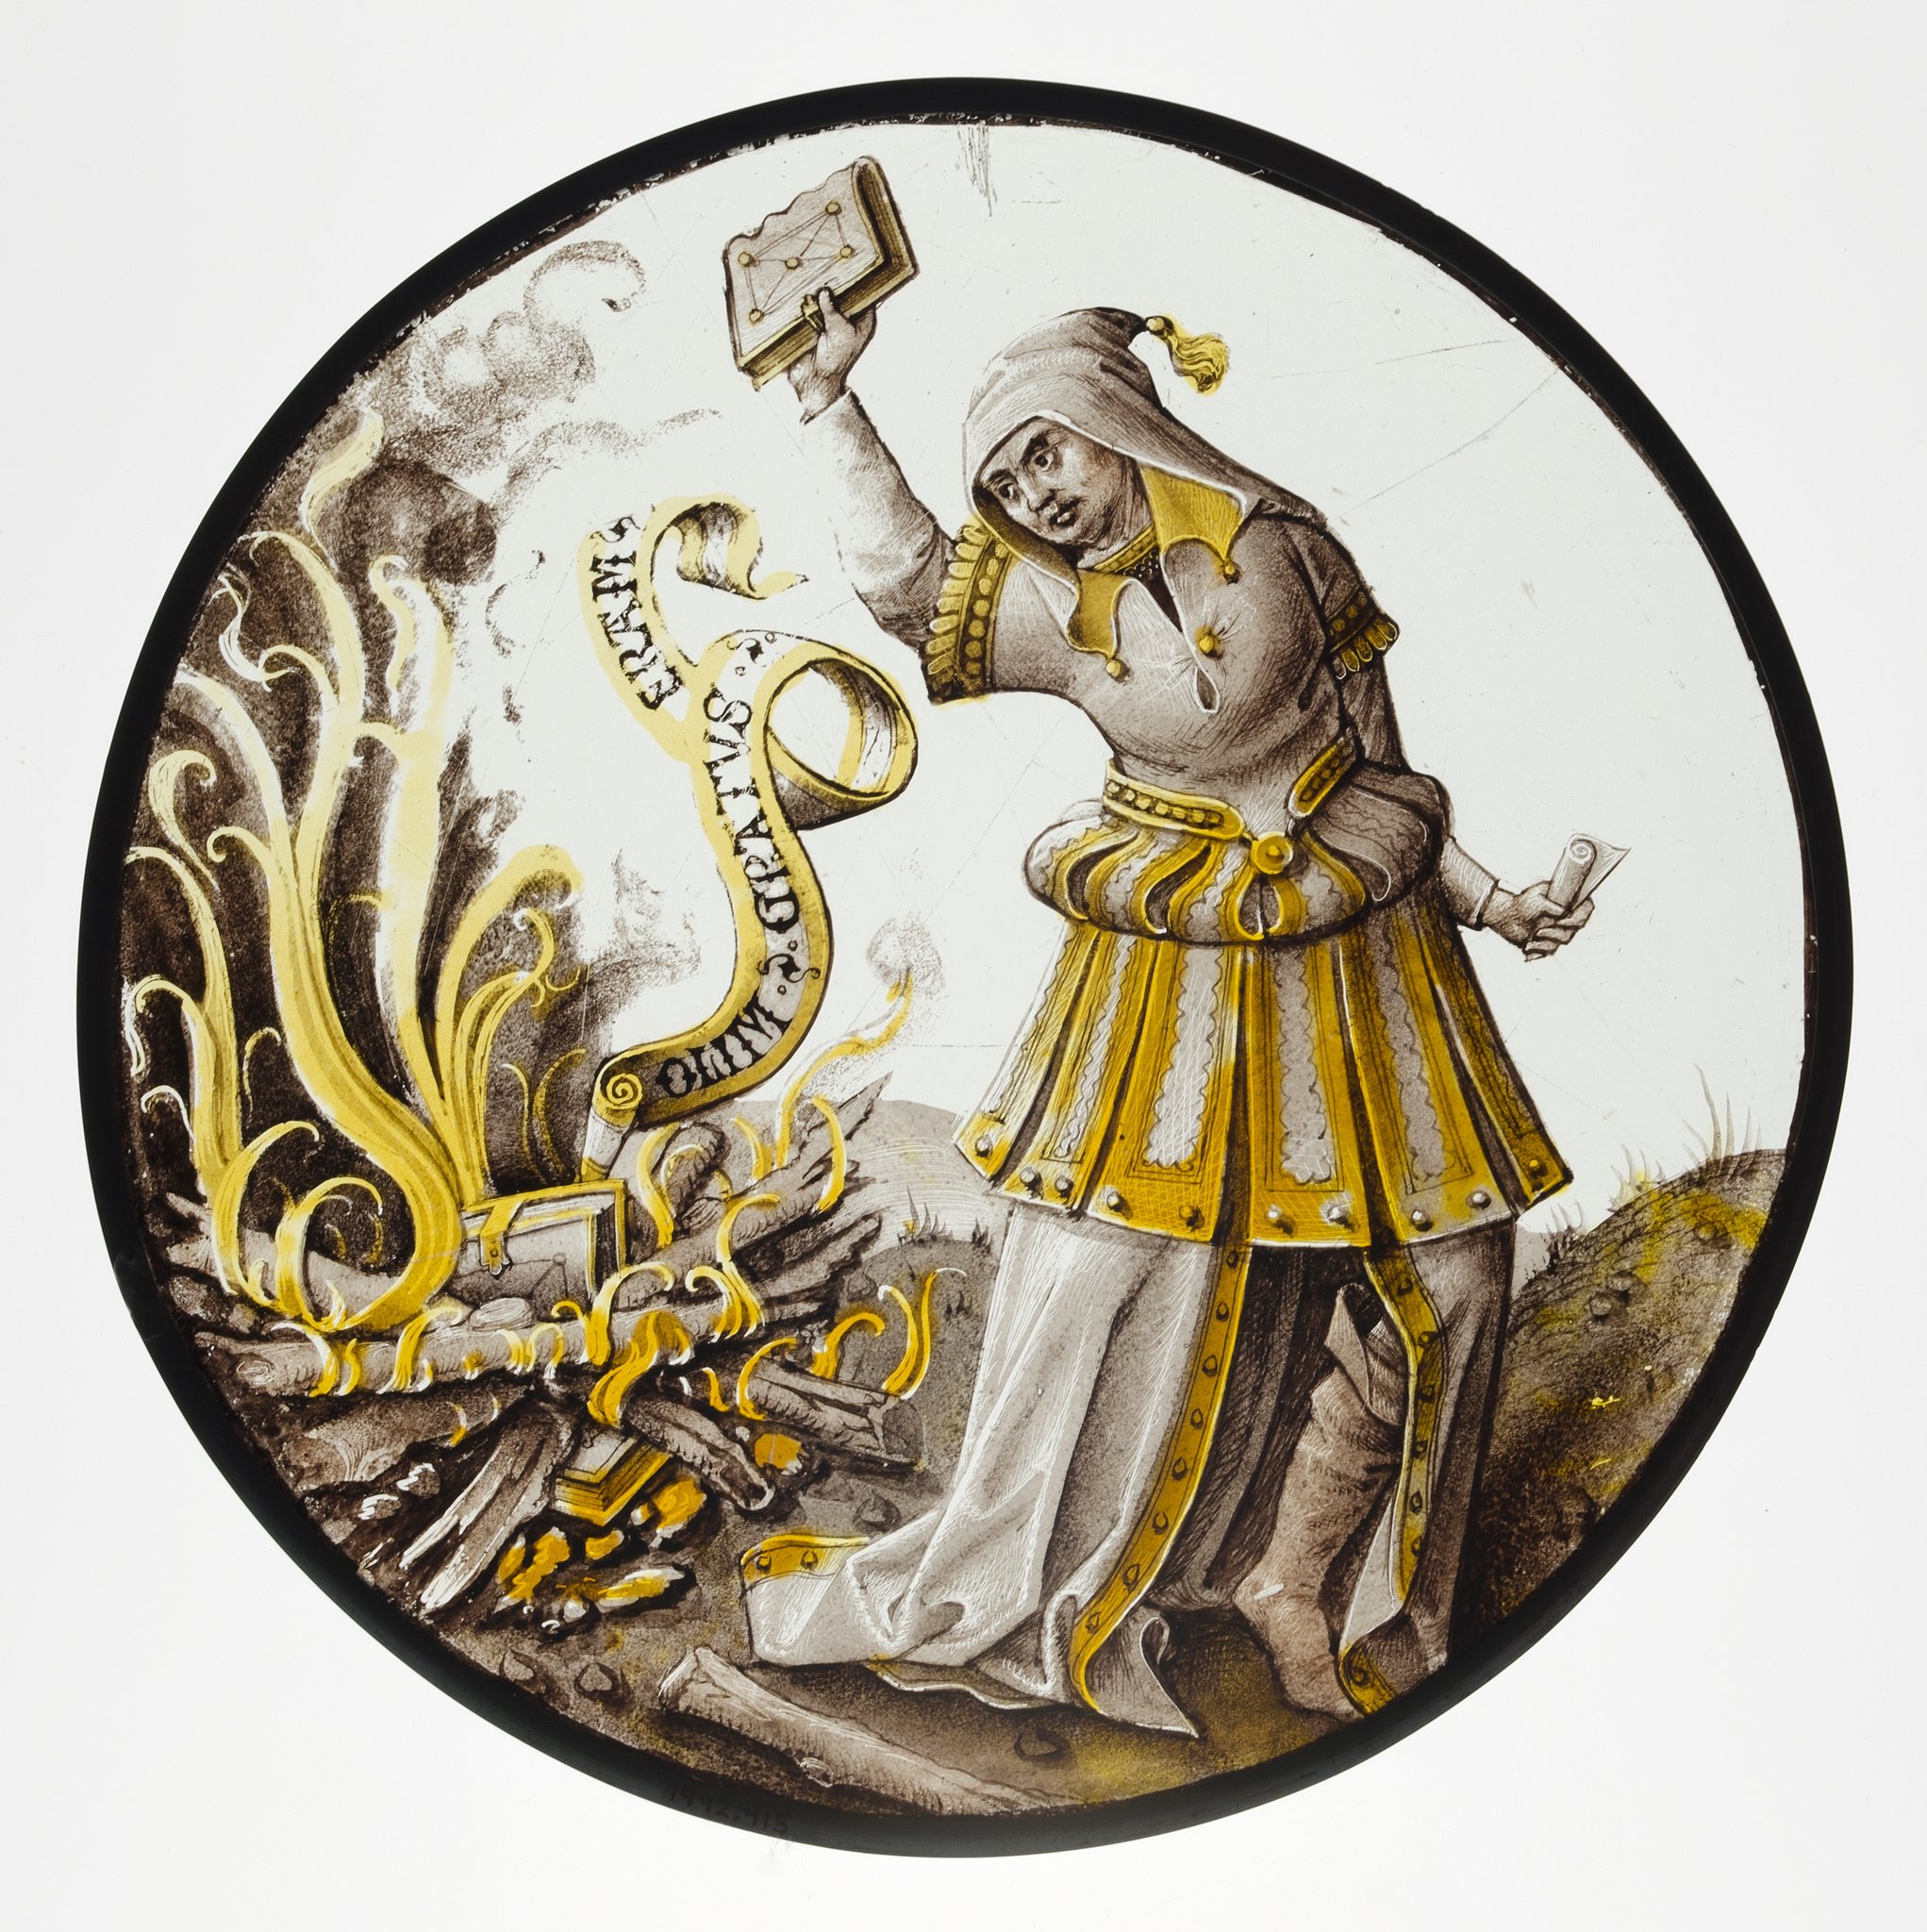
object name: roundel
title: Roundel with Allegorical Scene of Book Burning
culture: dutch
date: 1520-1530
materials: glass, paint, pigment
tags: books,fire